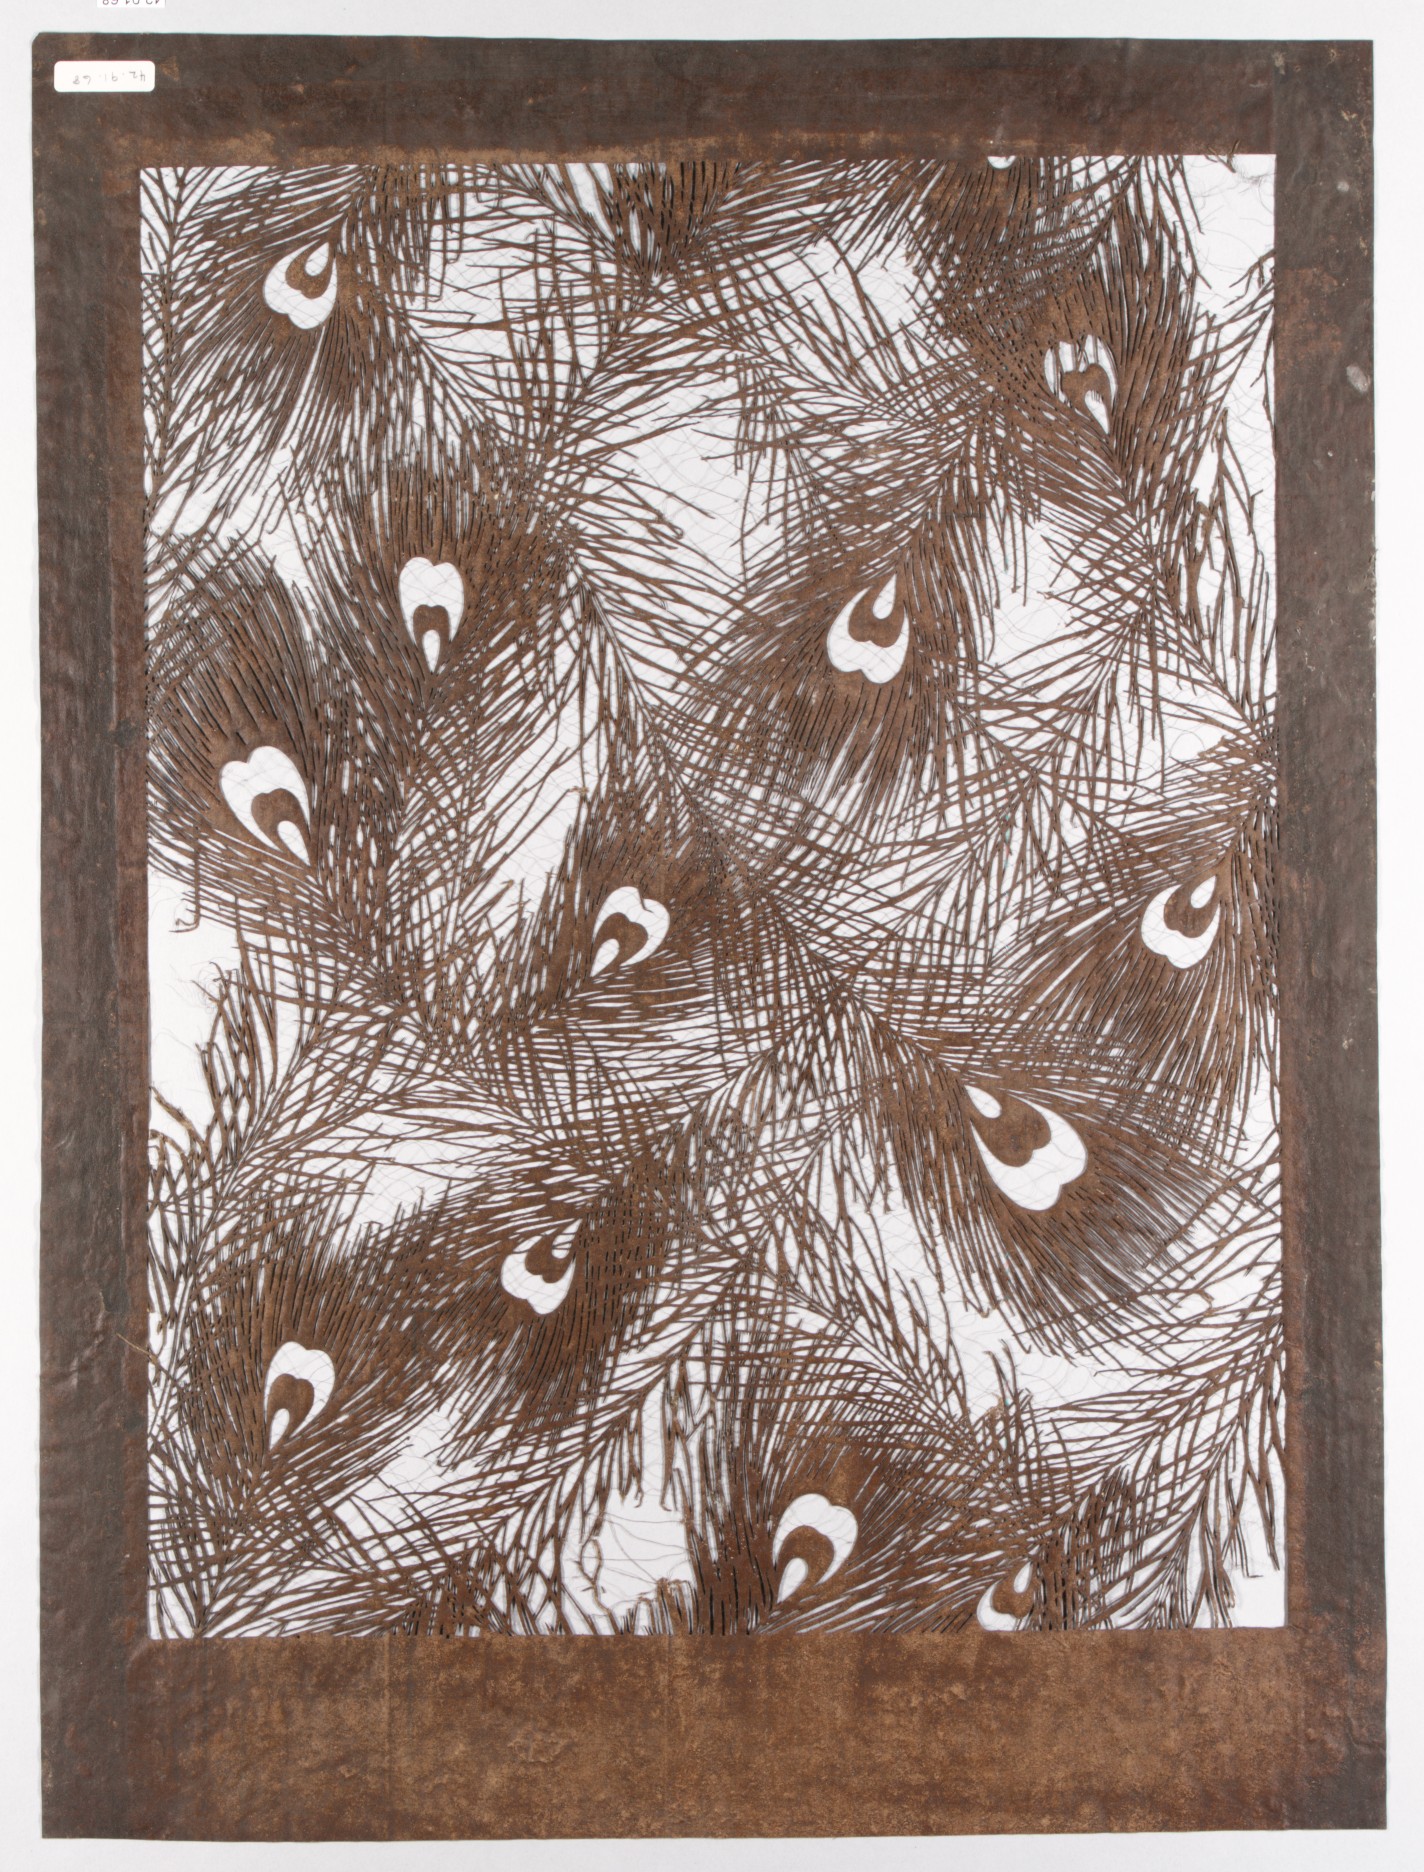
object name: stencil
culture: japanese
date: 1801-1900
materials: paper, silk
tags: feathers